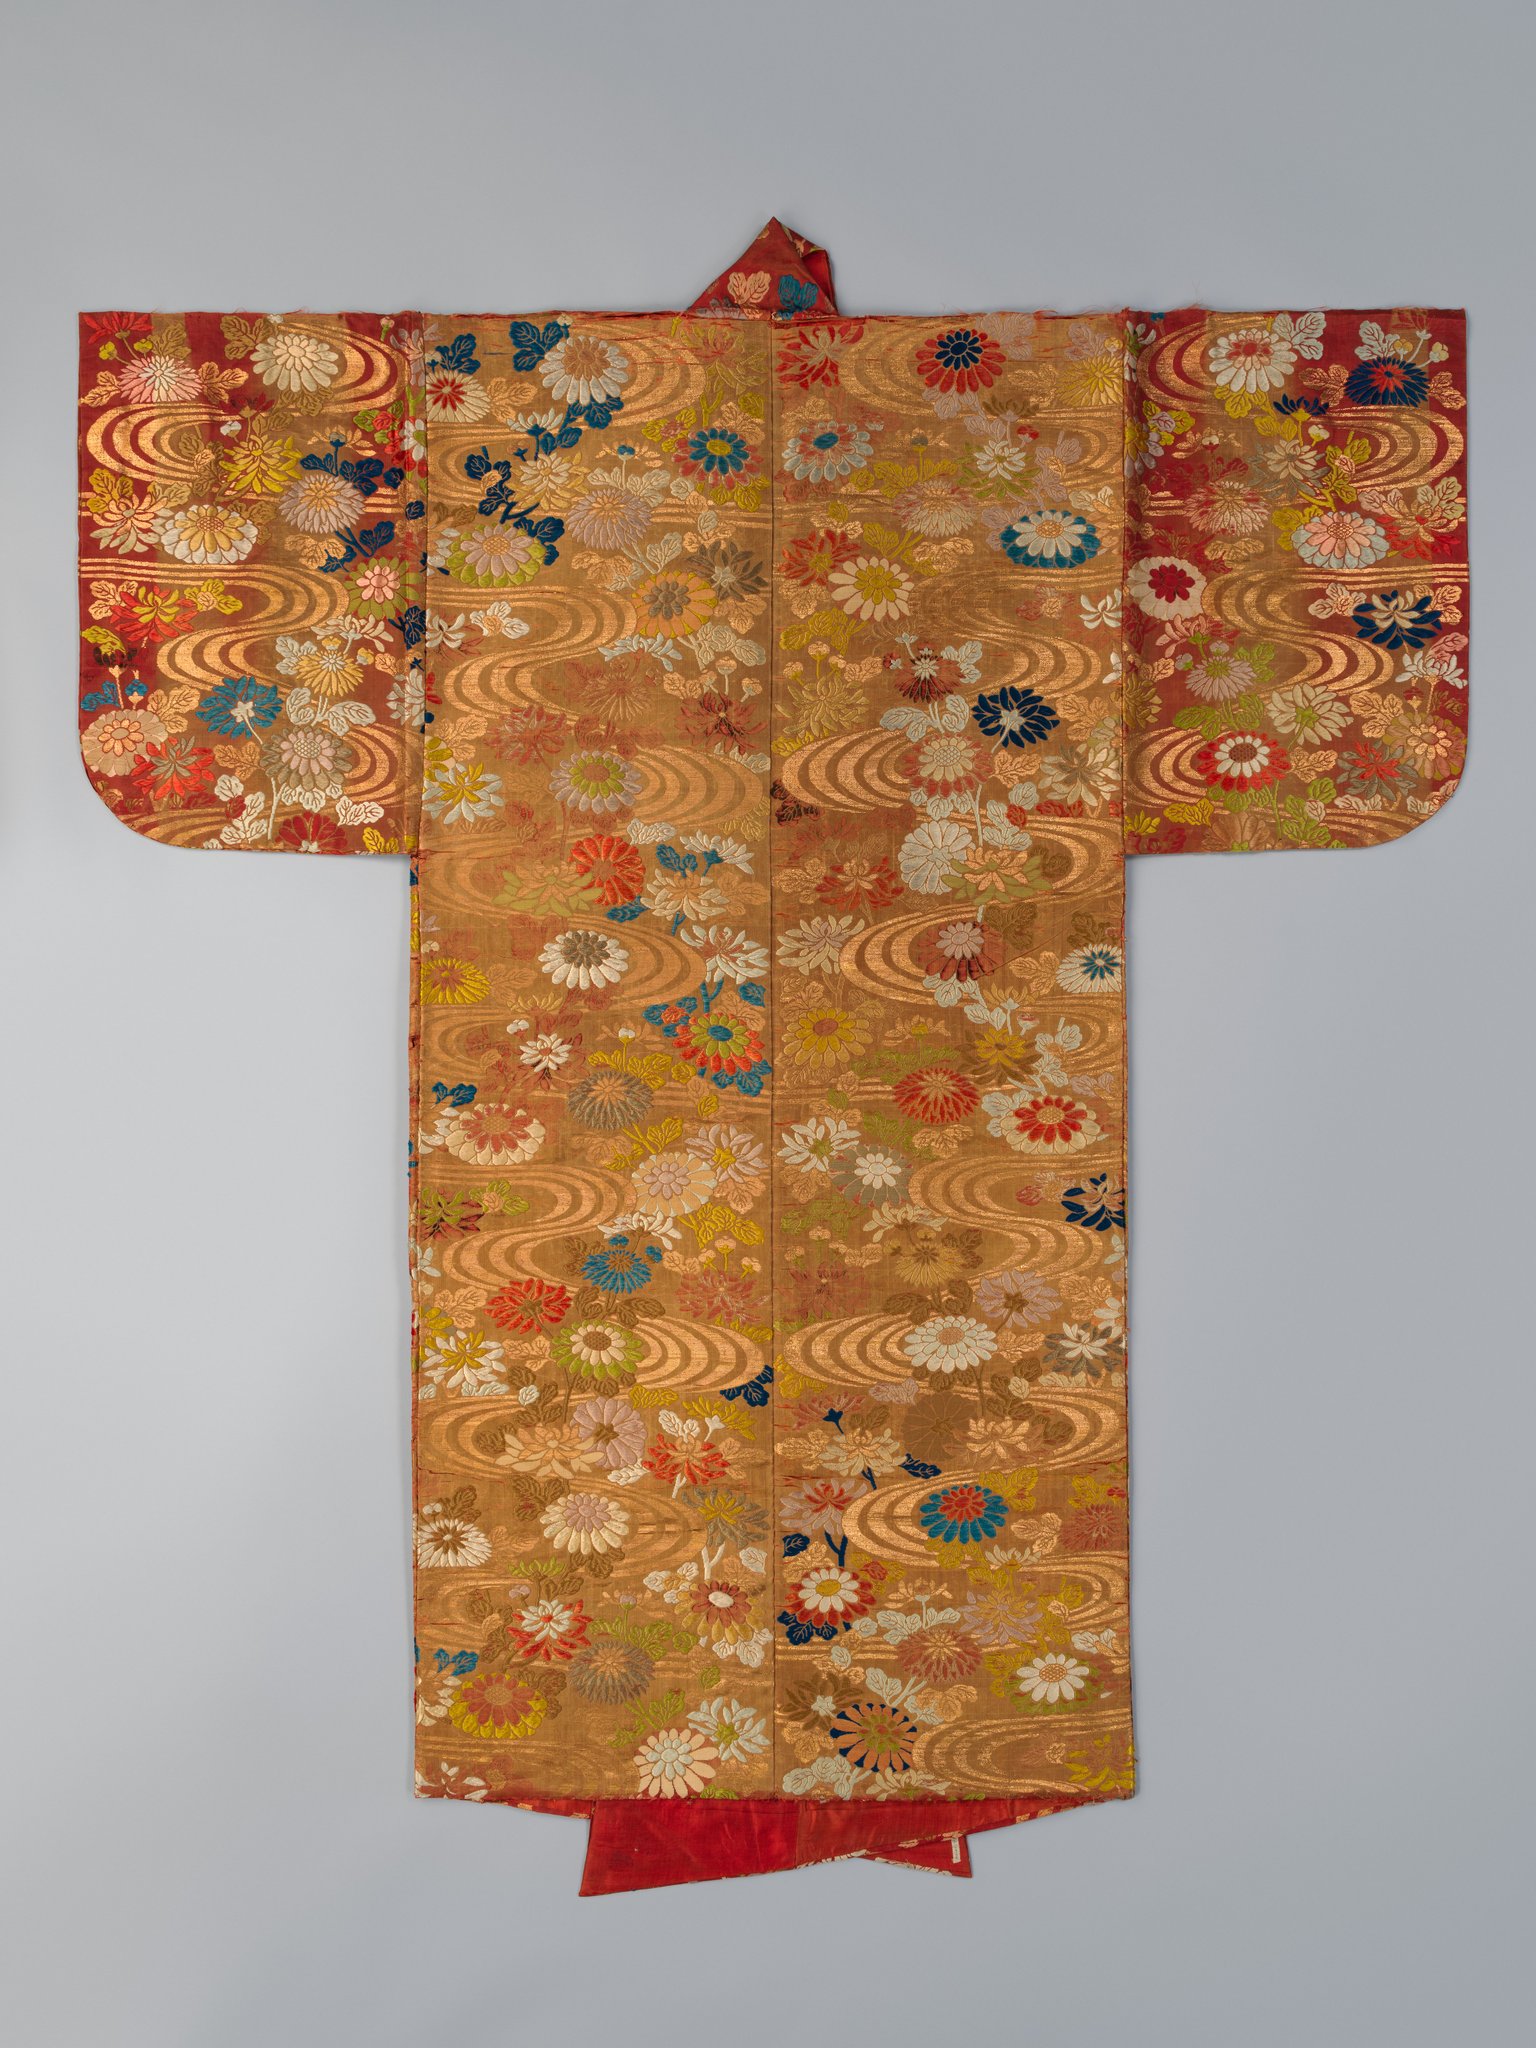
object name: noh robe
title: Noh Robe (Karaori)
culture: japanese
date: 1767-1833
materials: gold leaf, paper, silk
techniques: patterning, weave